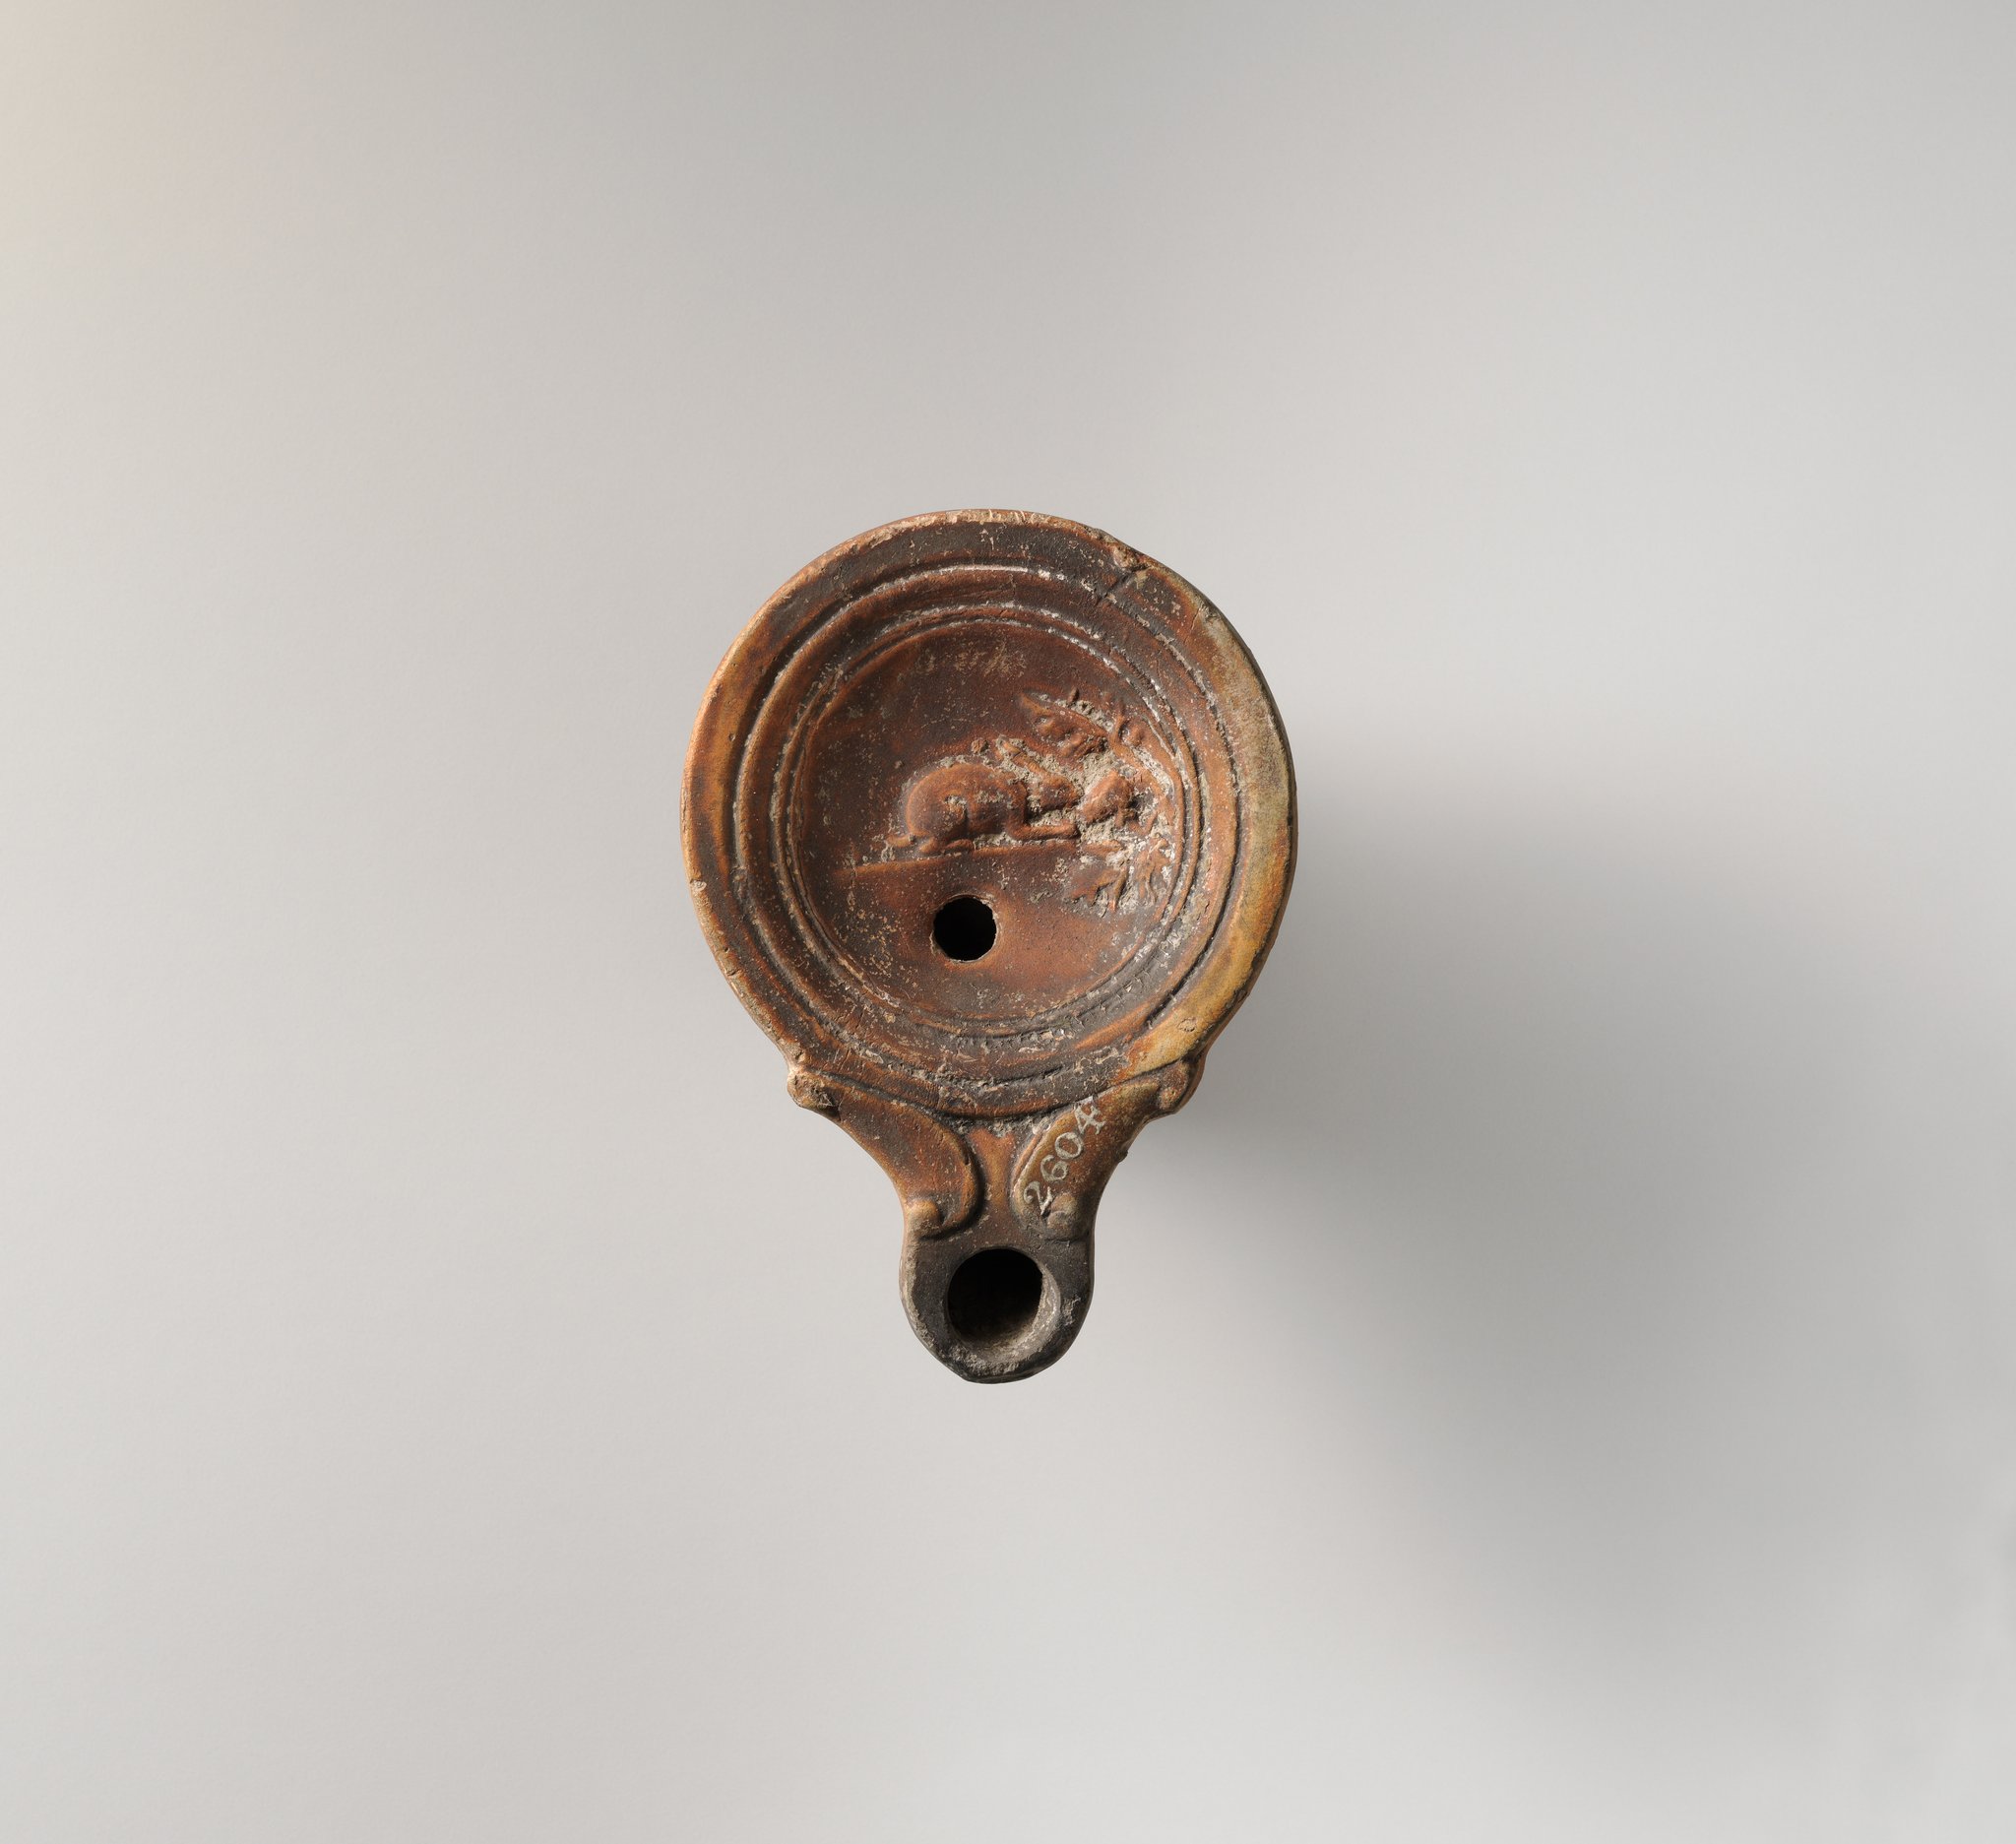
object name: lamp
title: Terracotta oil lamp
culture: roman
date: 40-100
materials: terracotta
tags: rabbits